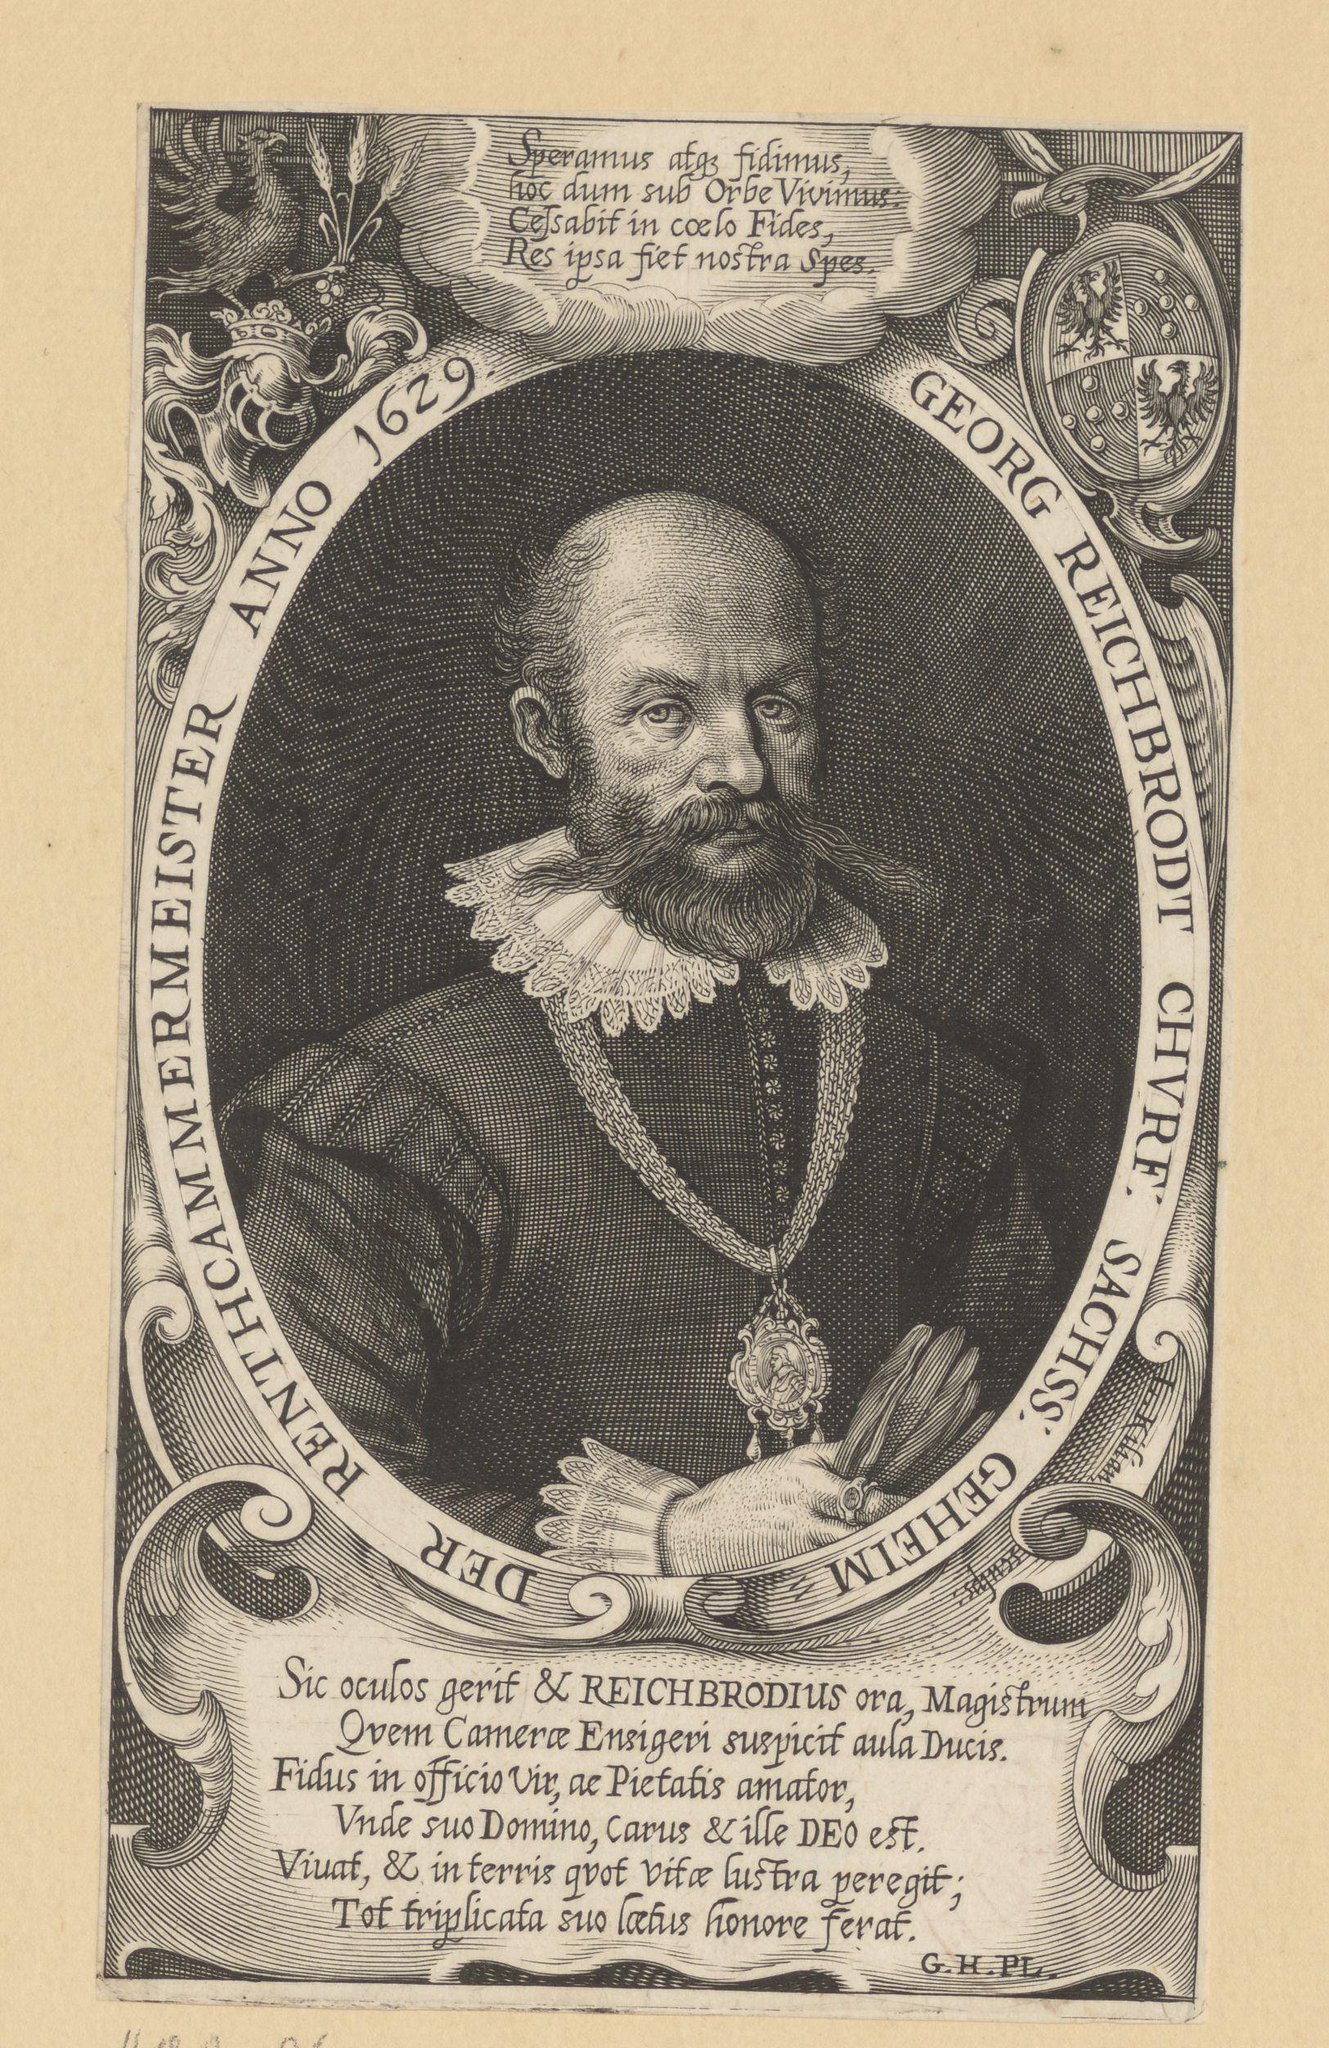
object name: print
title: Portret van Georg Reichbrodt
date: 1629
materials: paper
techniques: engraving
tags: treasurer, historical persons, pendant, trinket, 'breloque'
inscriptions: collector's mark: Lugt 240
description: Tekst in het Latijn in de omlijsting, de wolk bovenaan en in de cartouche.